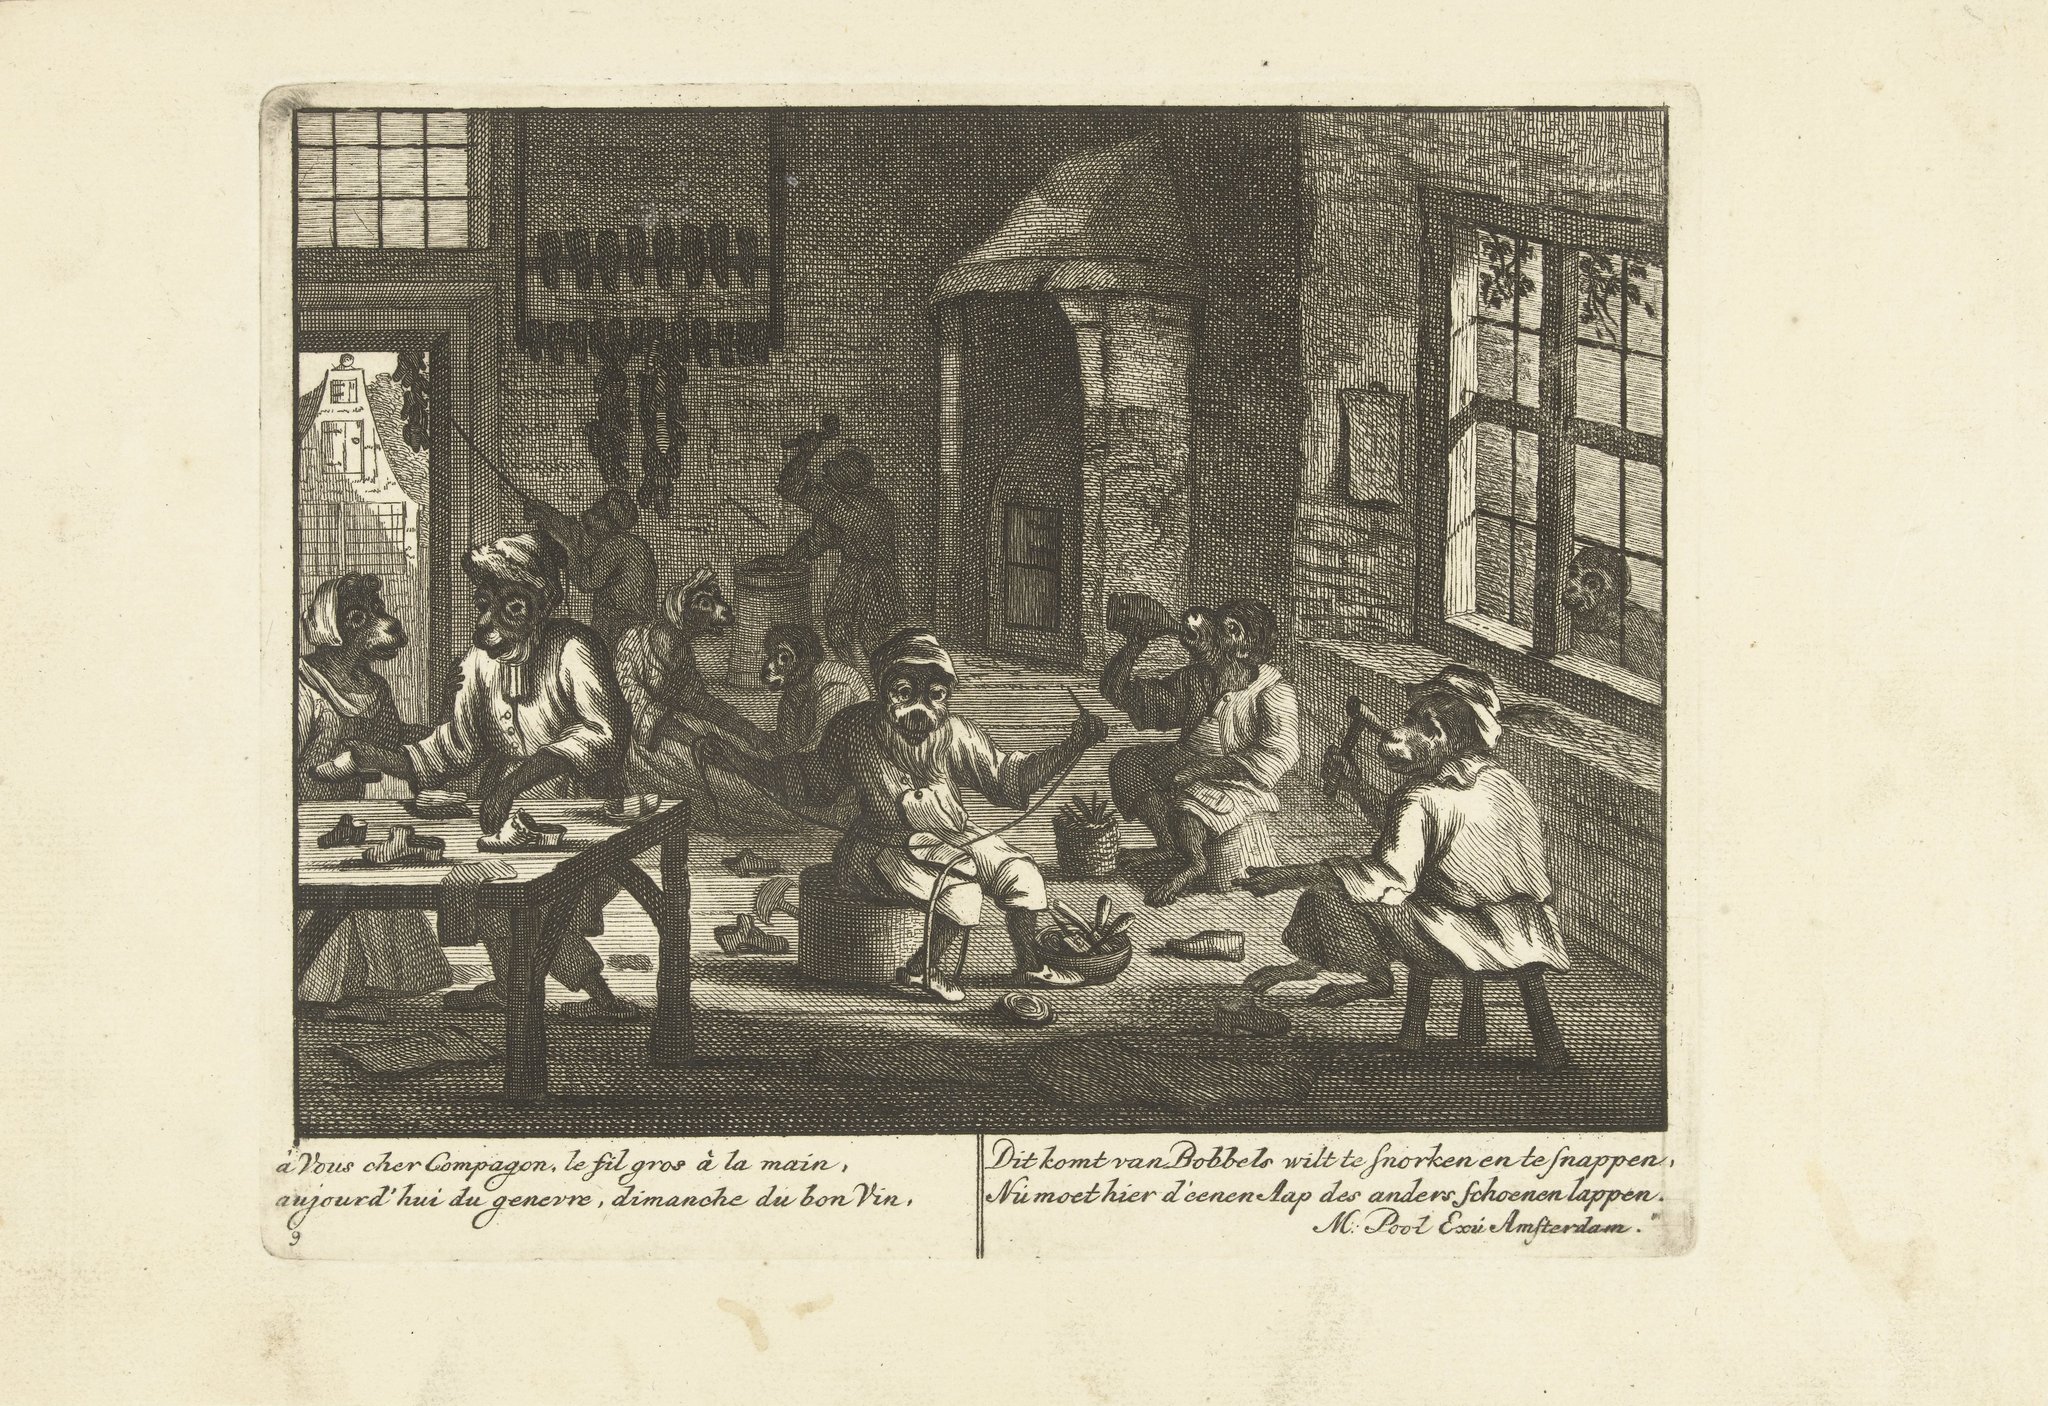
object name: print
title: Apenspel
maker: matthijs pool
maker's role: print maker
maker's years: 1676-1740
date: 1720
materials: paper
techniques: engraving, etching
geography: amsterdam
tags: monkeys, apes, animals acting as human beings, shoe-maker, cobbler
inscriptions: collector's mark: Lugt 2228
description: Apen als schoenmakers in een werkplaats. In het onderschrift versjes in het Frans en Nederlands. Prent nr. 9 in een serie van 16 prenten van ca. 1720 waarin apen als mensen figureren in allerlei huishoudelijke taferelen.